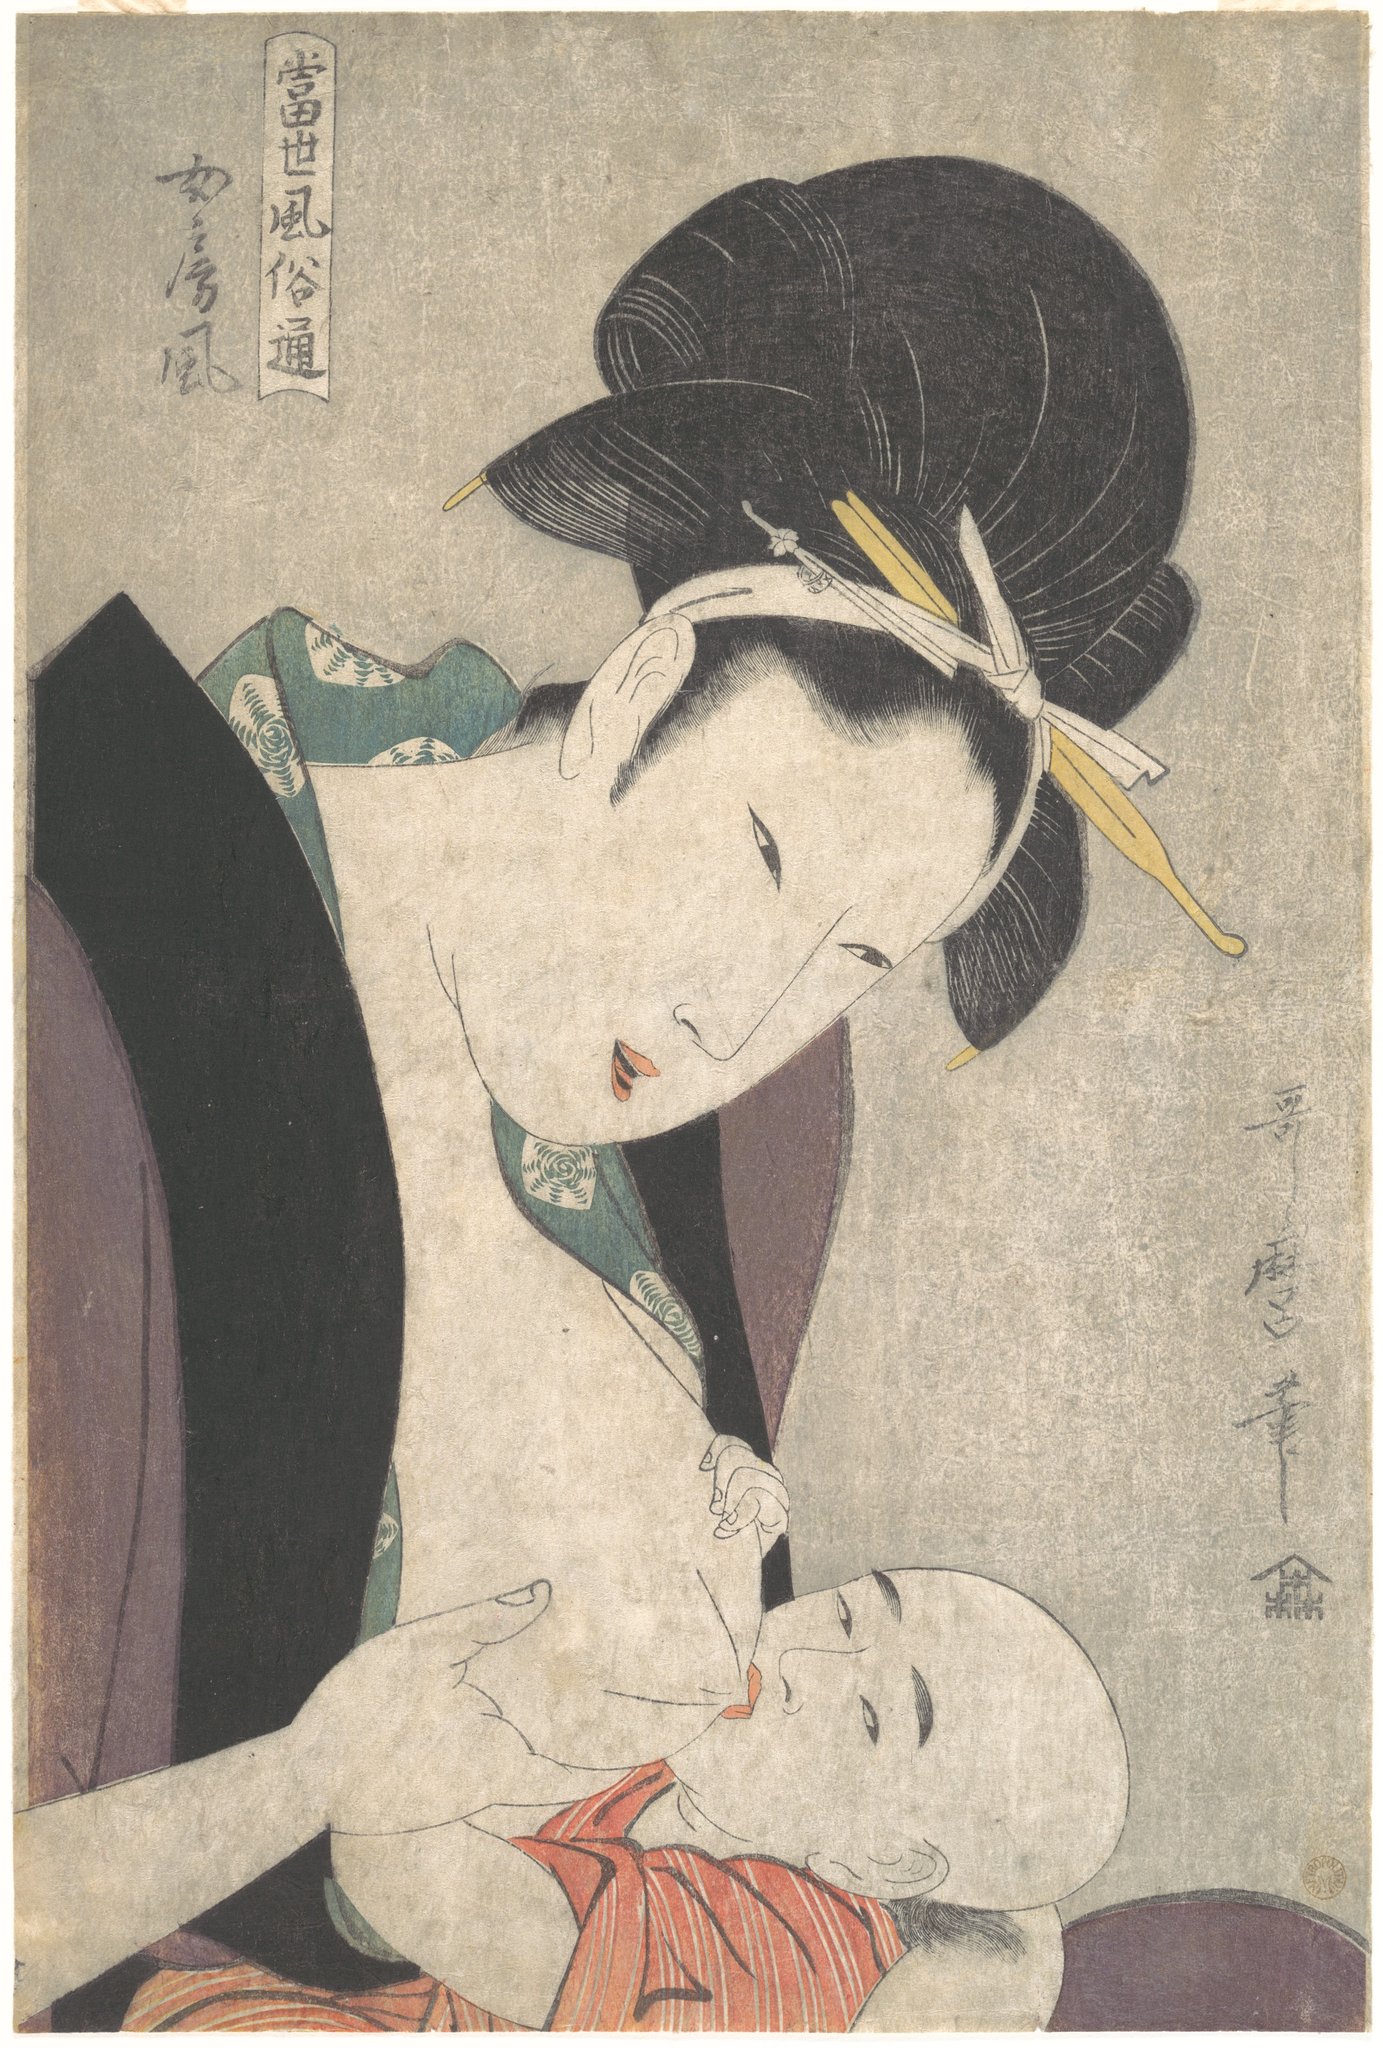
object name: print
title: “Wife,” from the series Connoisseur of Modern Customs (Tōsei fūzoku tsū)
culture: japanese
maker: kitagawa utamaro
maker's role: artist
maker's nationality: japanese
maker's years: 1754-1806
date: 1790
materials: ink, paper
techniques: woodblock print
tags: infants,mothers